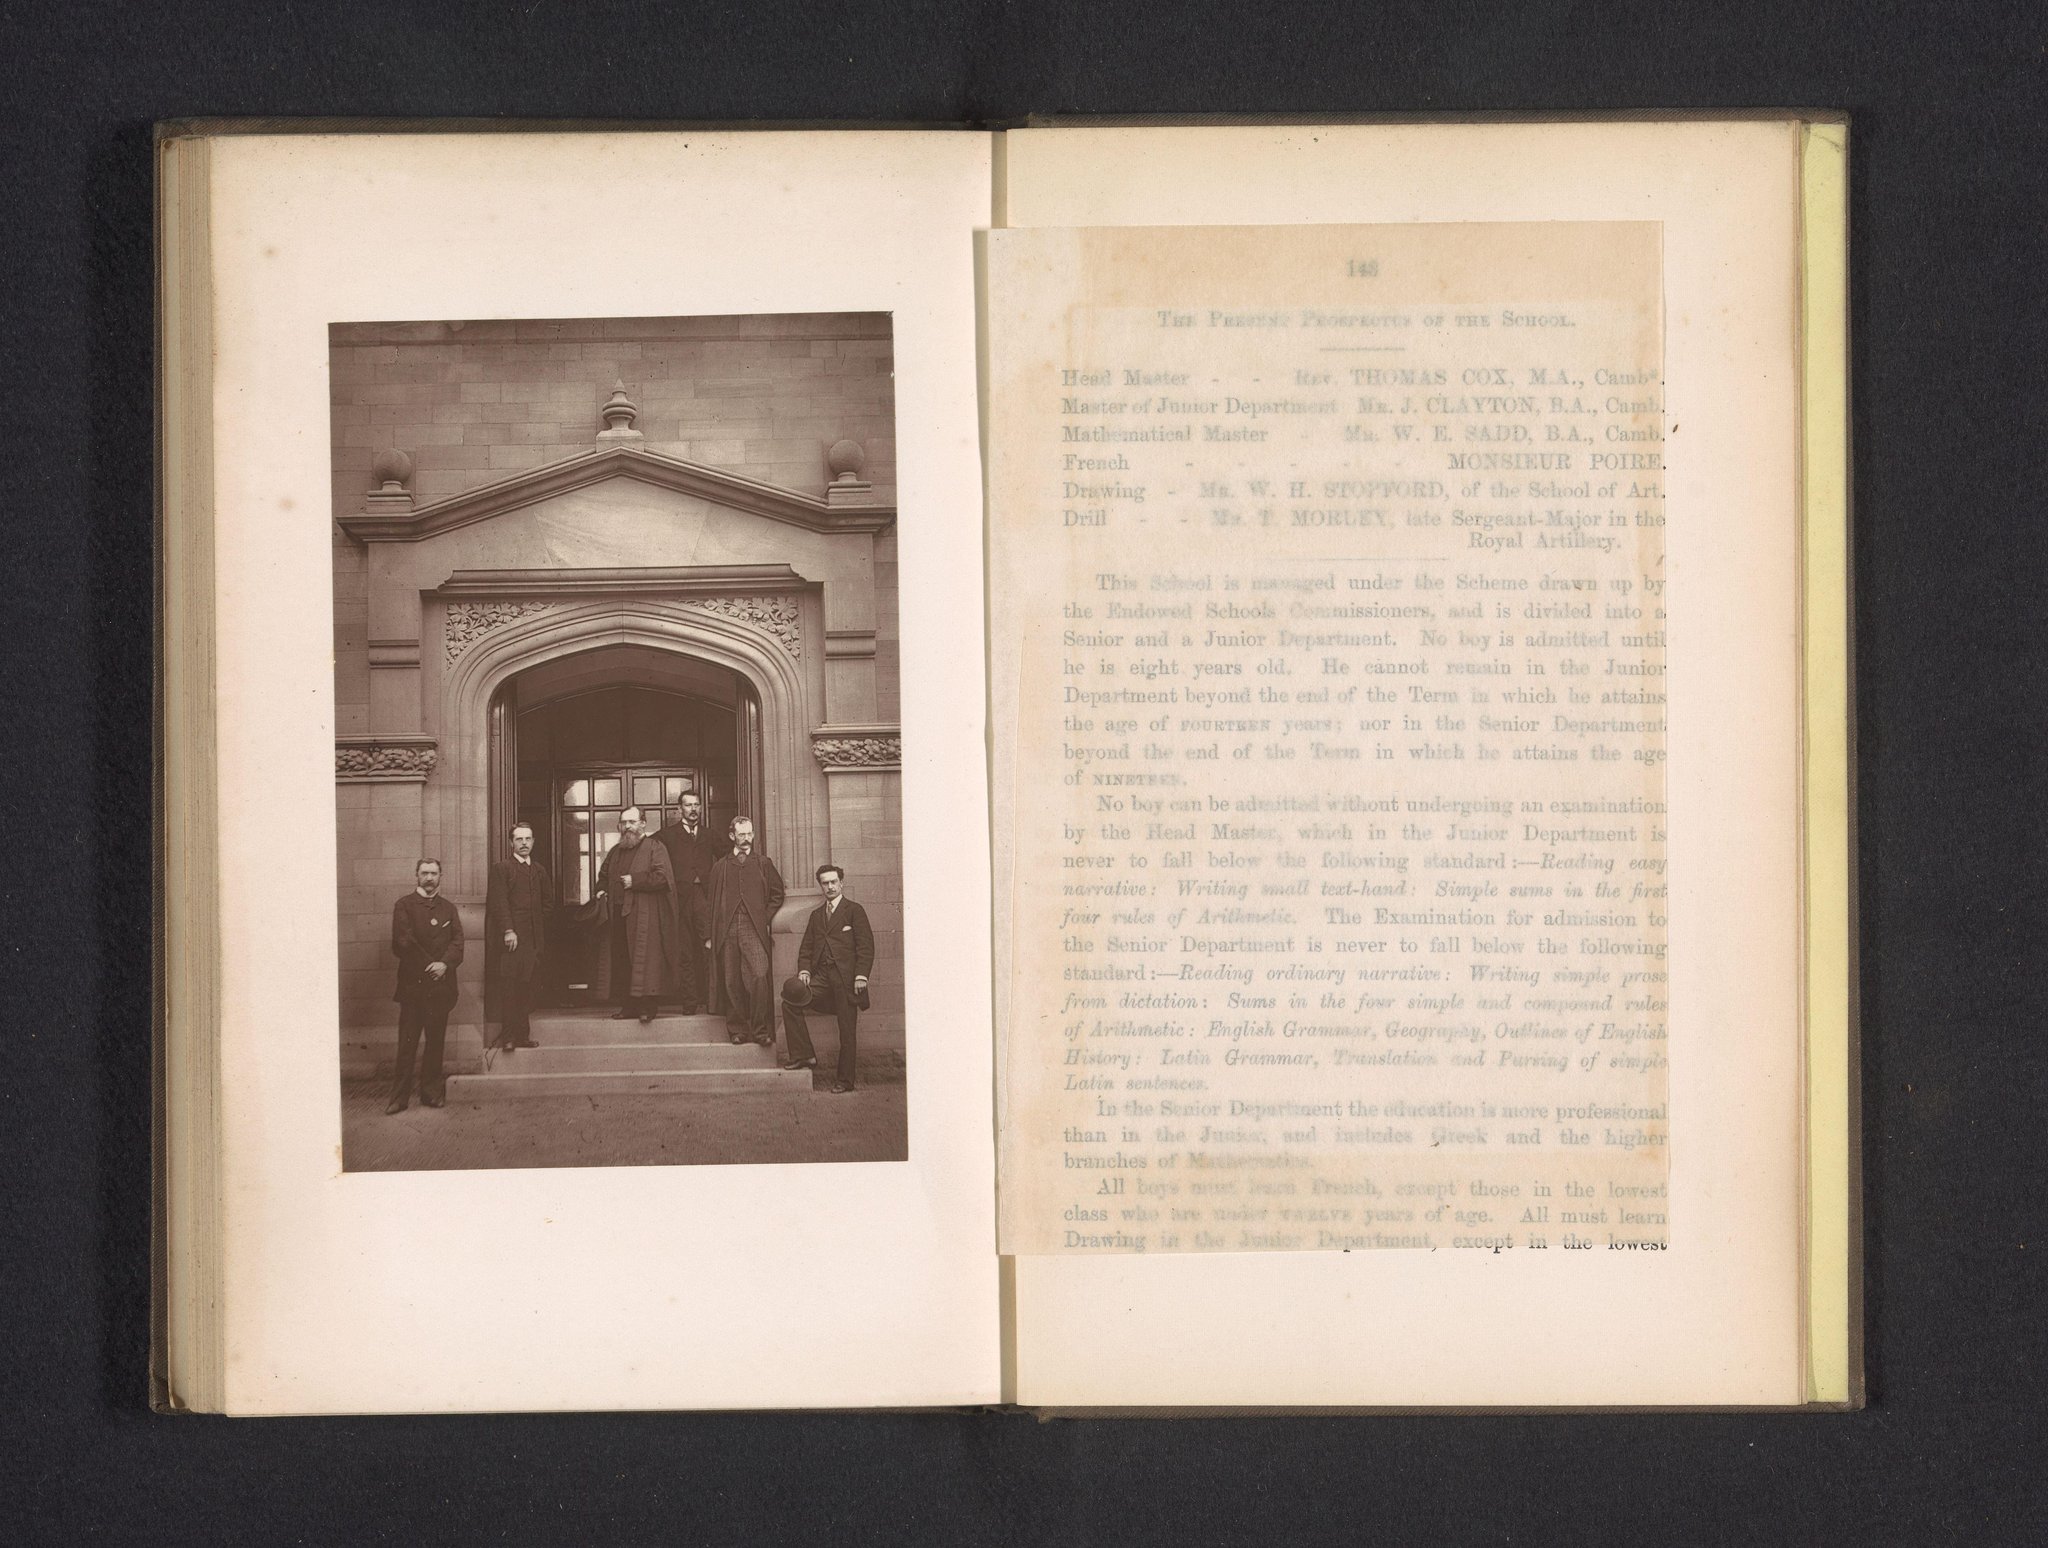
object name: page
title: Zes docenten en schoolhoofden voor The Free Grammar School of Queen Elizabeth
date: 1879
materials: paper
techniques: woodburytype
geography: halifax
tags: scholastic education, tuition (+ teacher, professor), university building, college